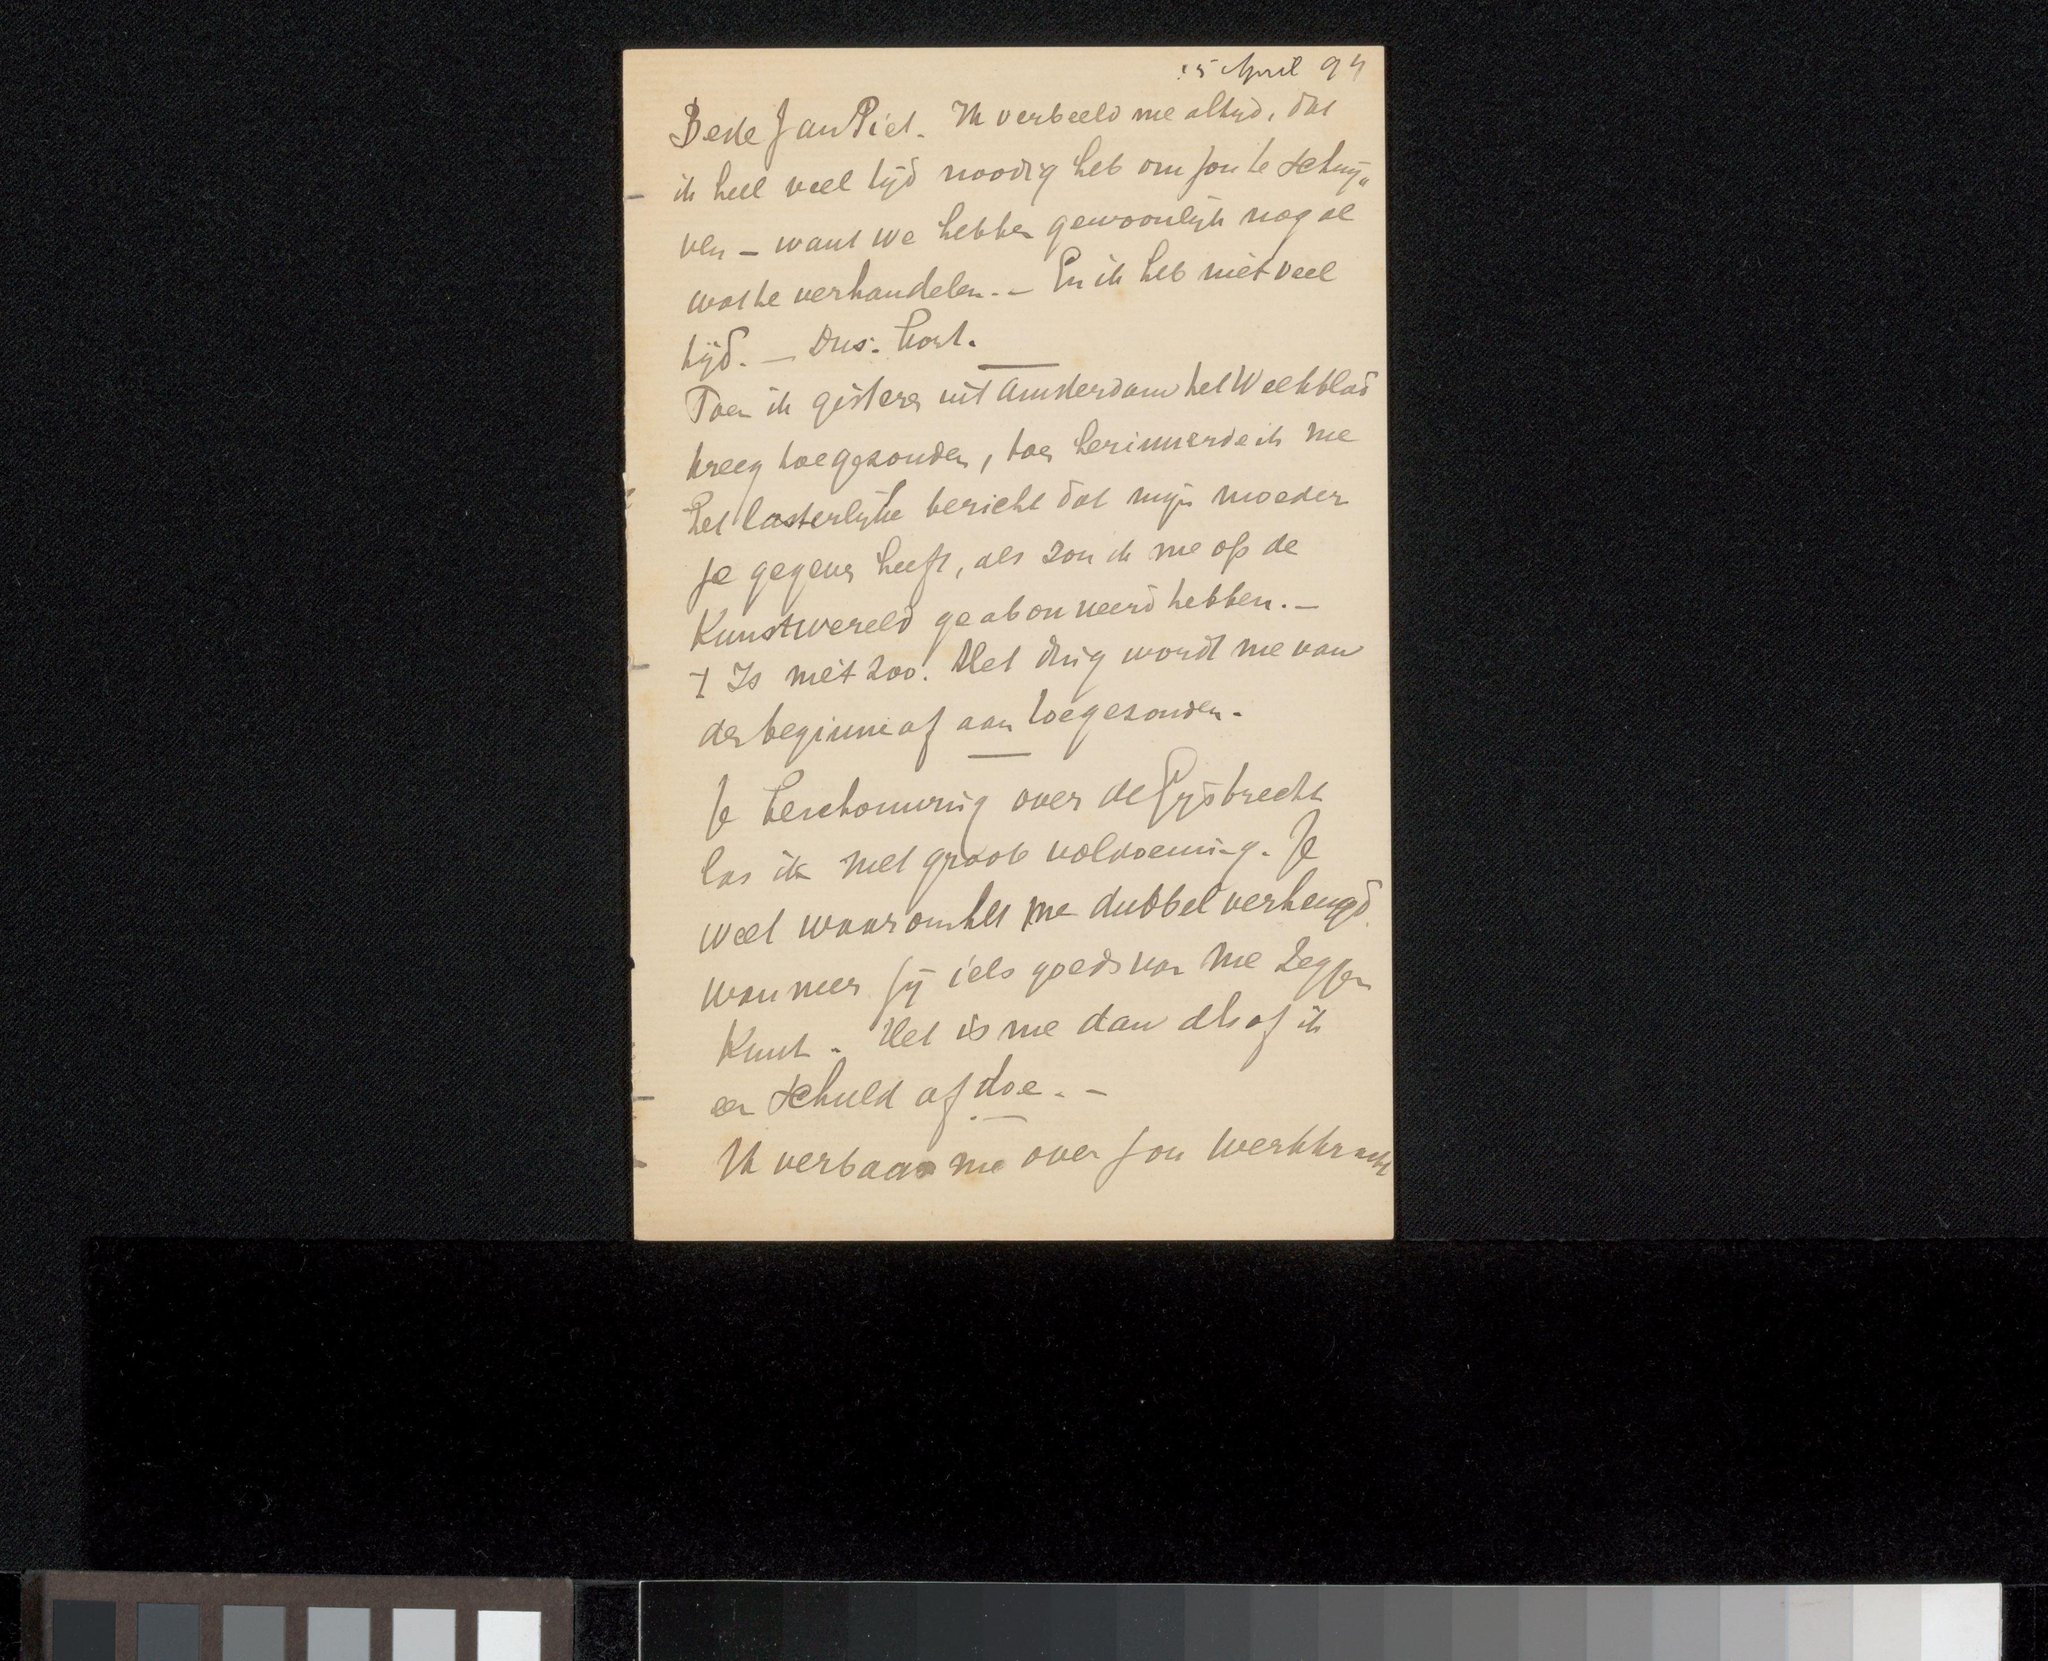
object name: letter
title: Brief aan Jan Veth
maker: antoon derkinderen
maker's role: draughtsman, painter, print maker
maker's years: 1859-1925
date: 1874-1925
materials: ink, paper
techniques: pen, writing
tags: dordrecht, painter, print maker, draughtsman, designer, jan veth, pierre joseph hubert cuypers, pierre cécile puvis de chavannes, paris, conservator, eugène emmanuel viollet-le-duc, drawing, historical persons (portraits and scenes from the life), money, printed matter, den bosch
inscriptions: collector's mark: ‘RPK’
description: Brief gedateerd 15 April 94 in latere hand.